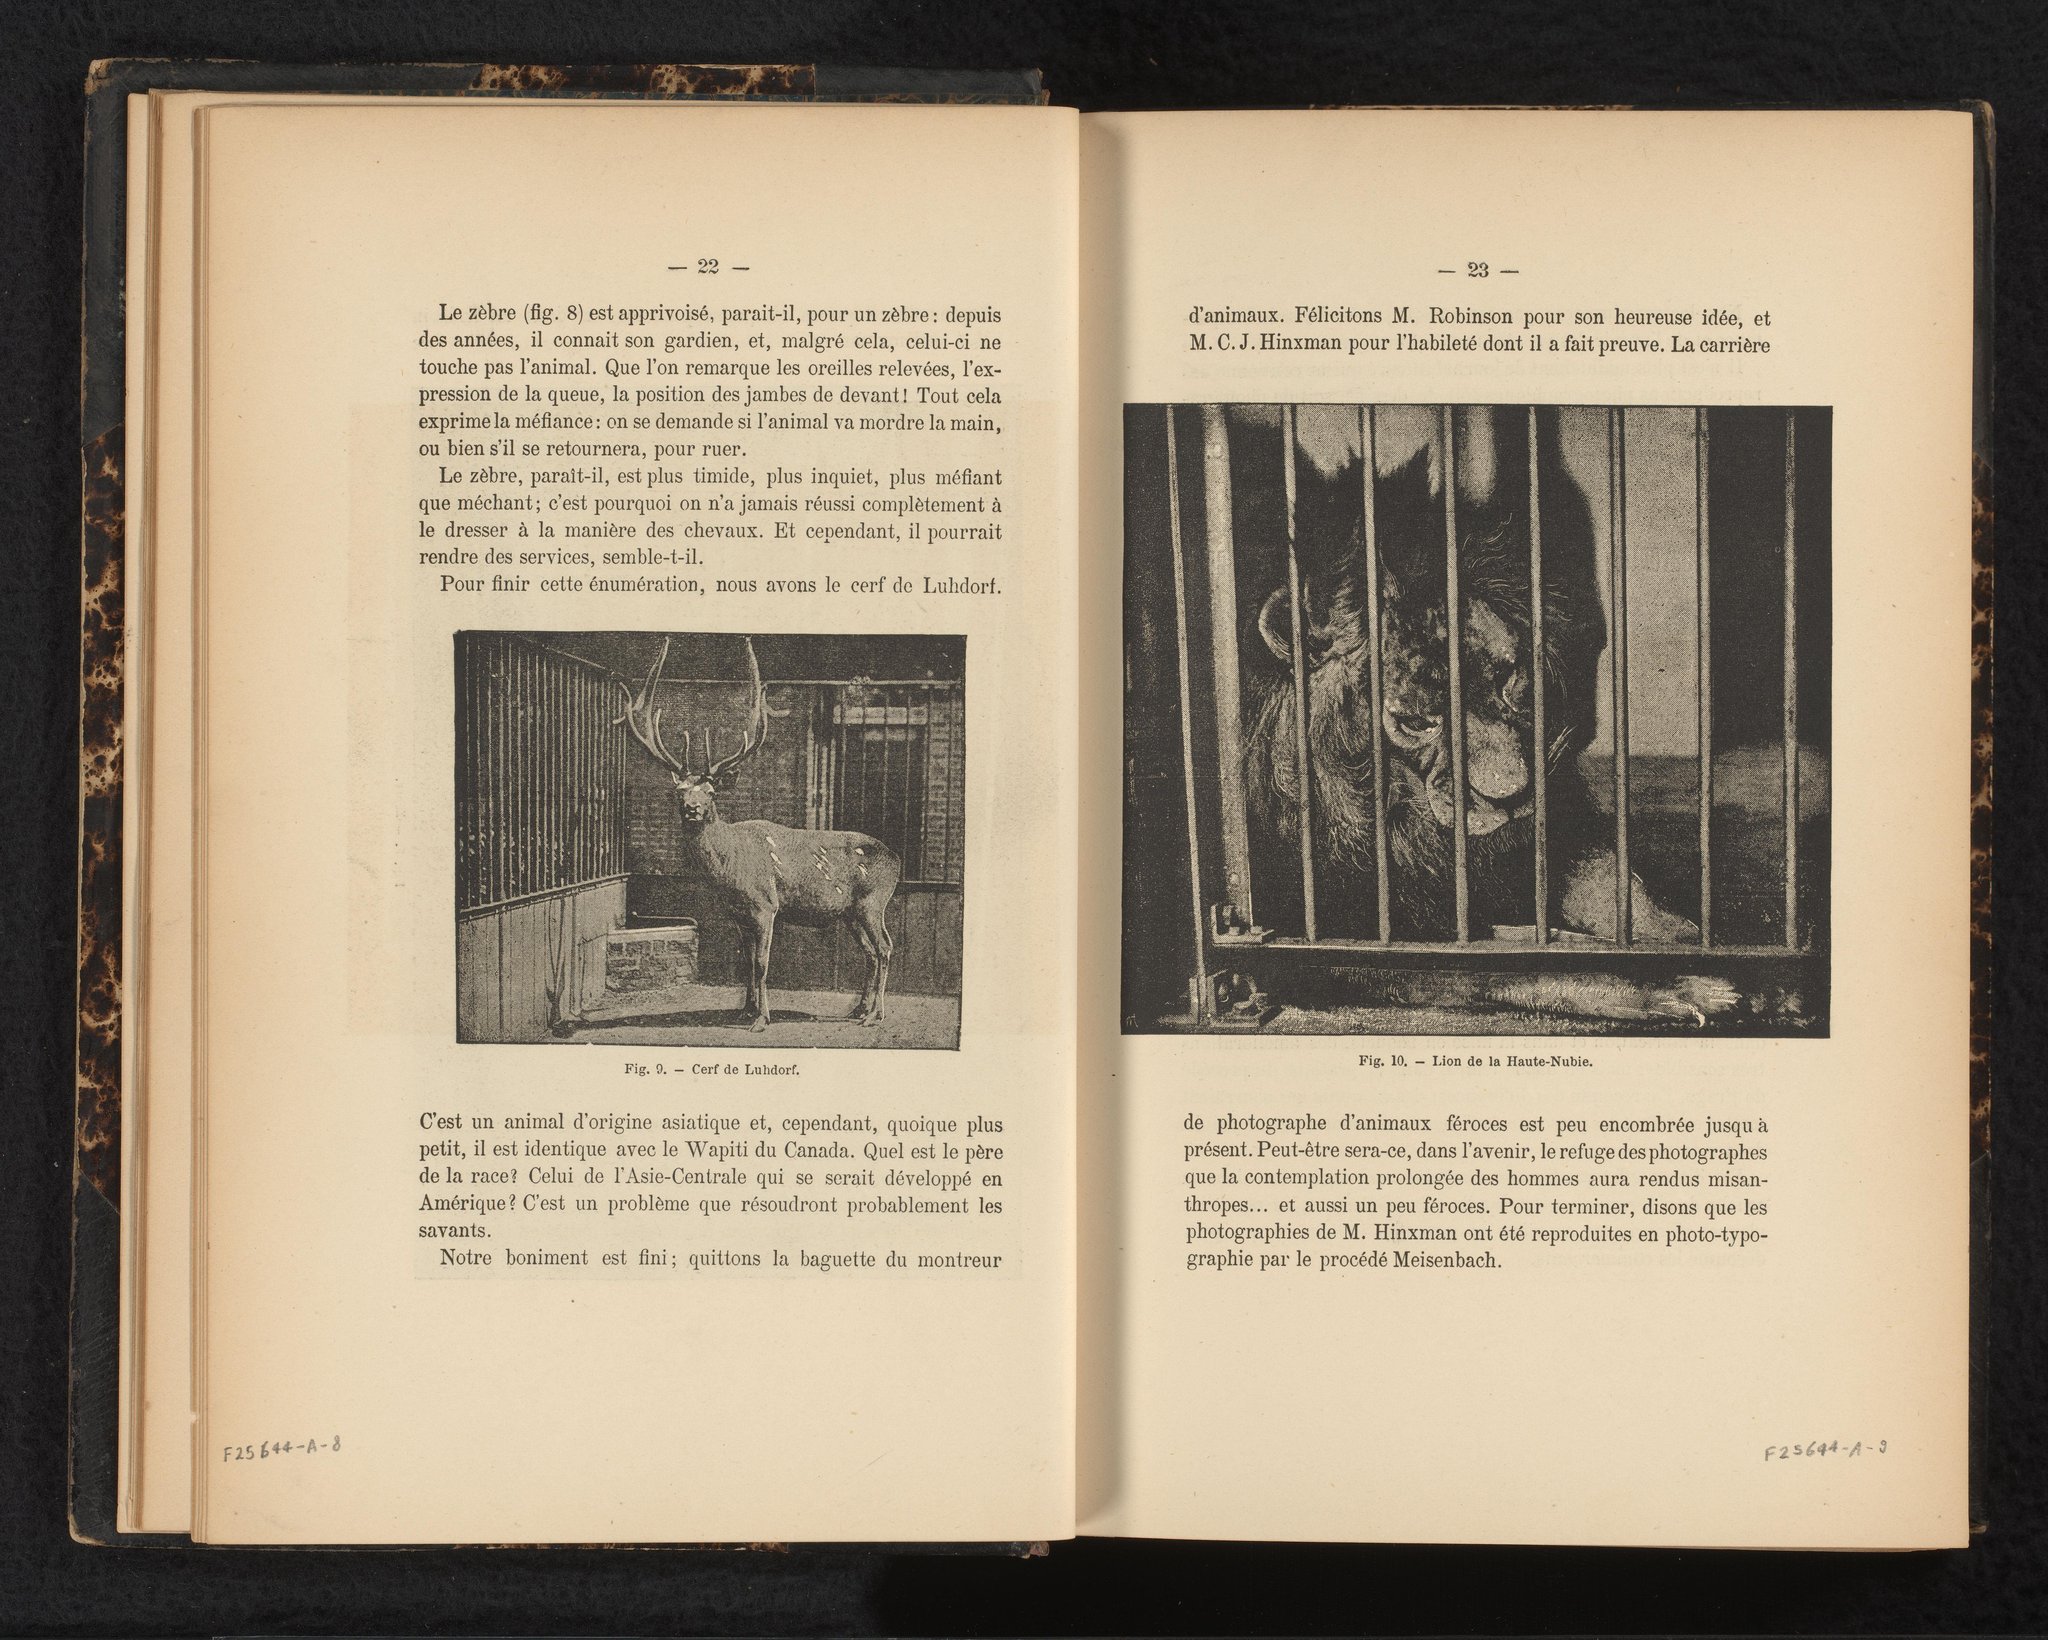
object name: page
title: Leeuw in de London Zoo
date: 1882-1887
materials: paper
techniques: autotype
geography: london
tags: beasts of prey, predatory animals: lion